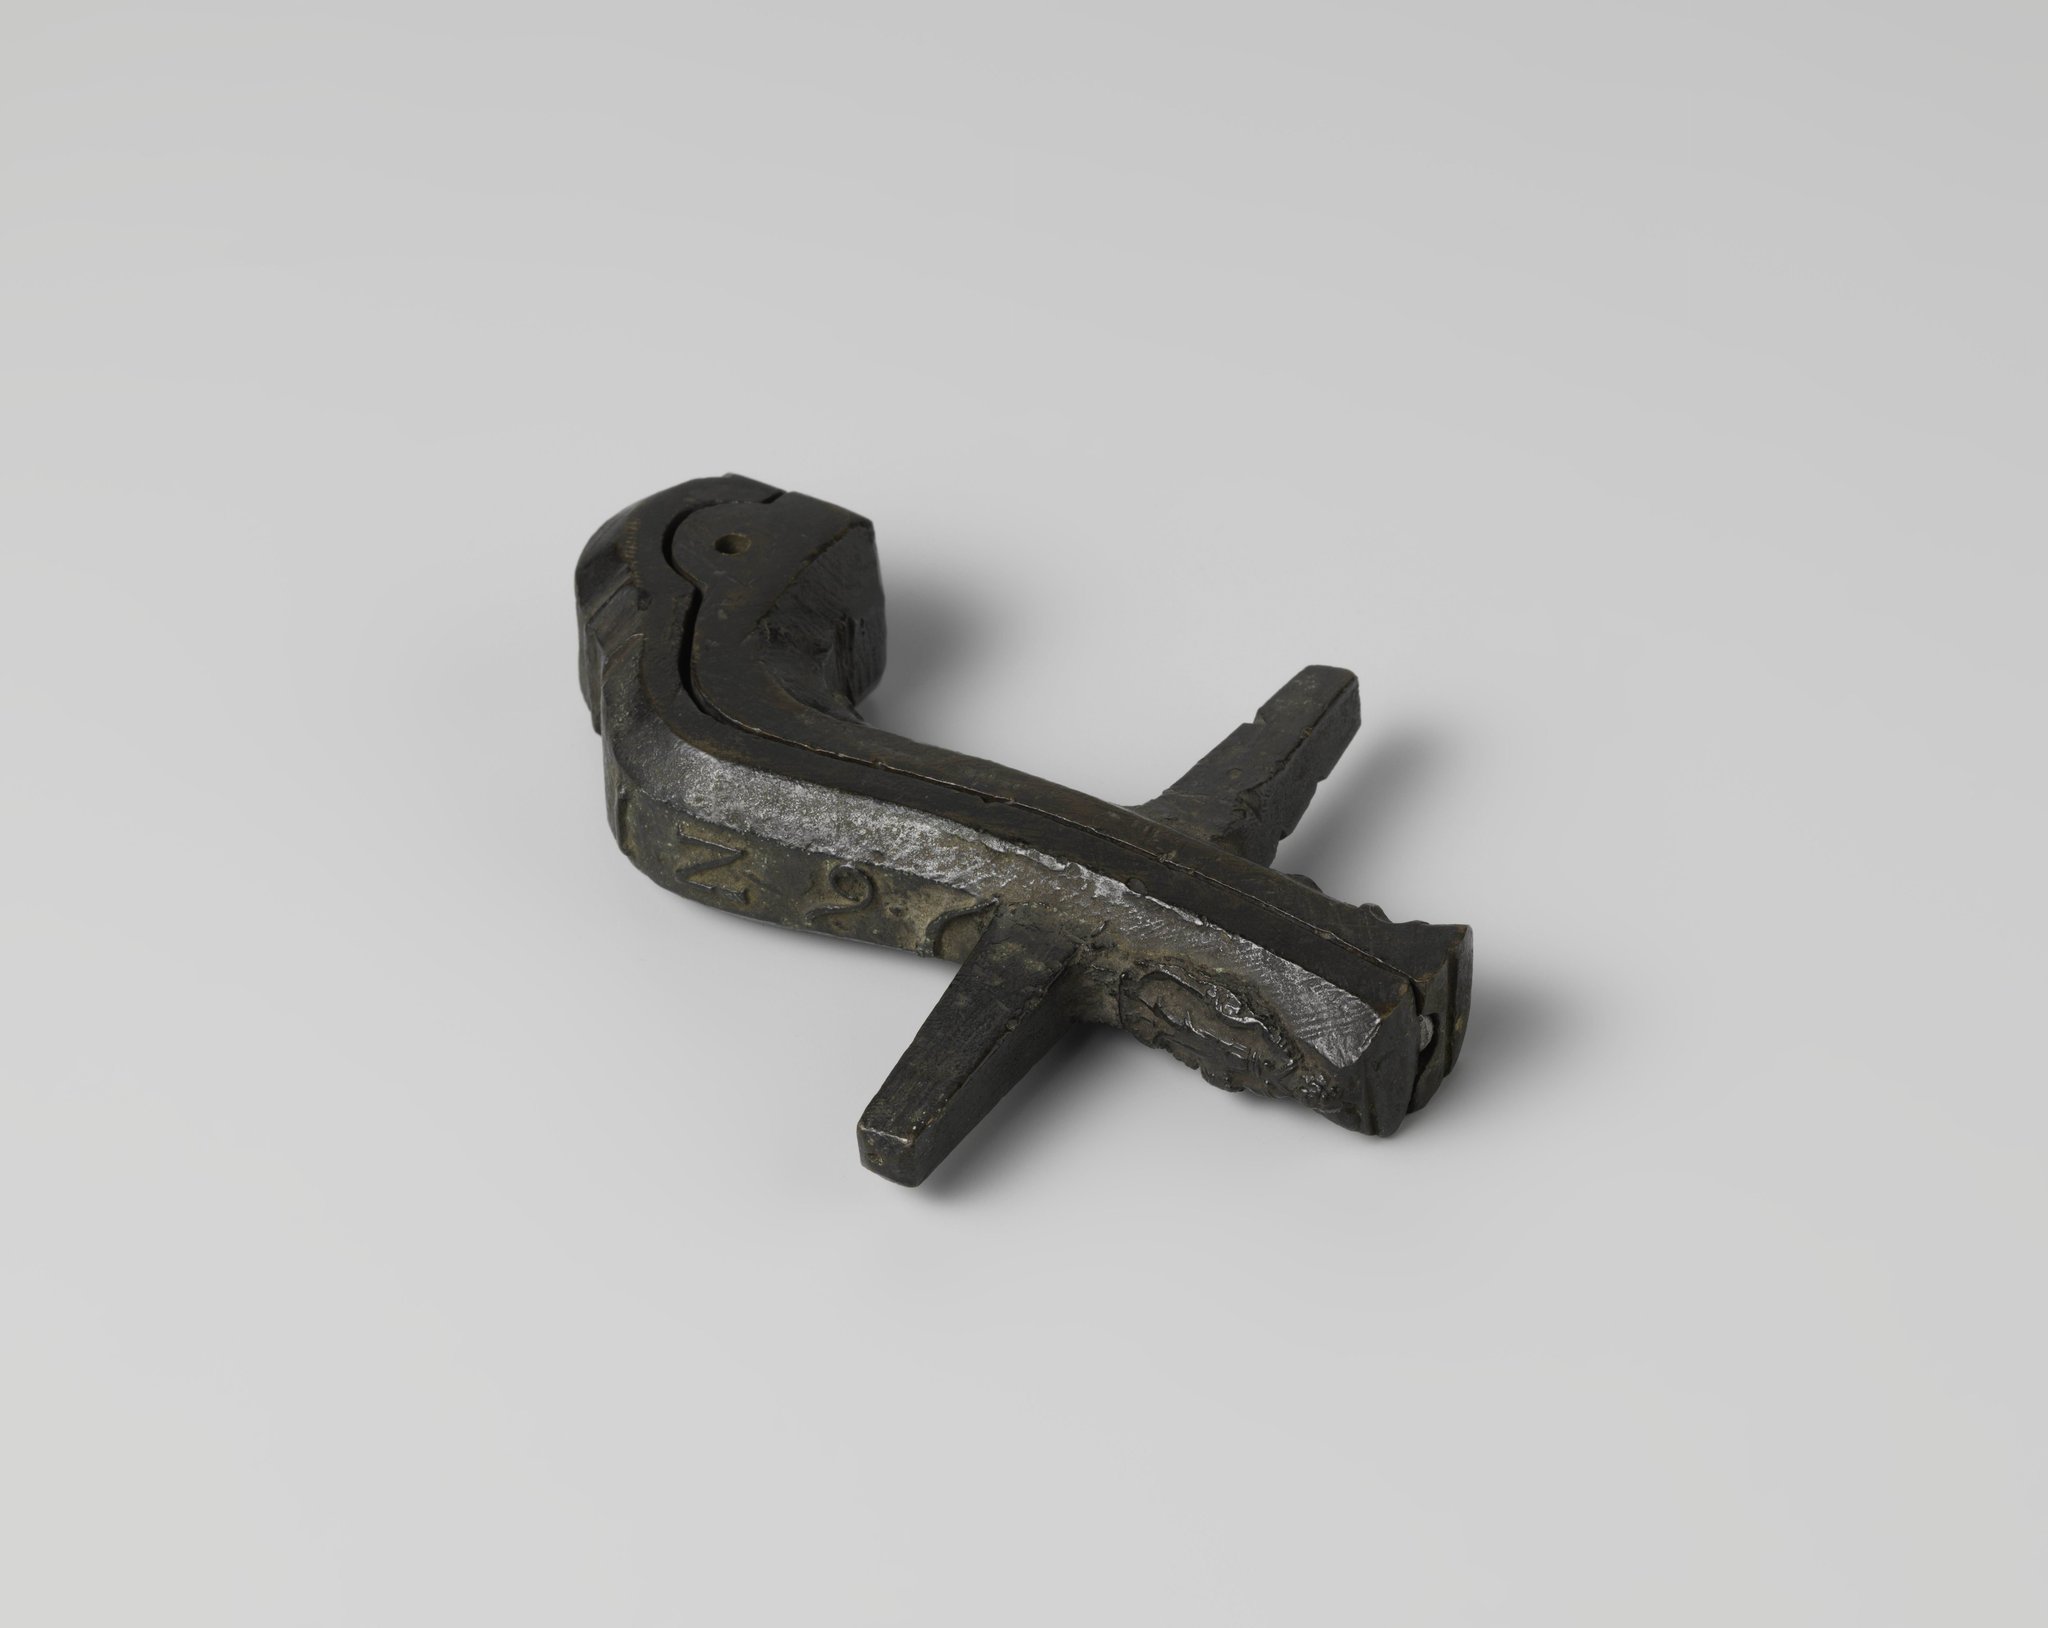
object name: flask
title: Gietvorm voor het handvat van een tinnen kan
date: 1621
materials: brass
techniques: casting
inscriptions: monogram: ‘JVS’, date: ‘1621’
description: Mould for the handle of a pewter tankard. Brass. Netherlands, 1621.